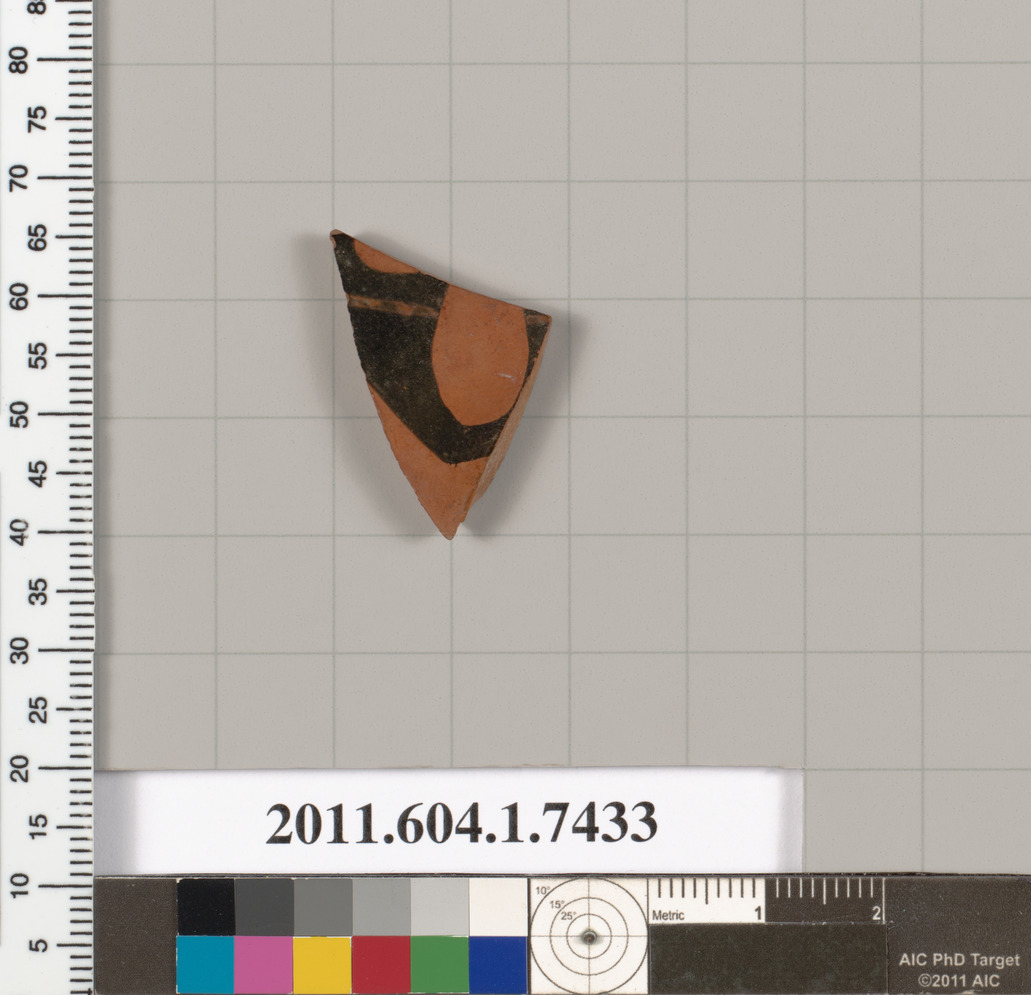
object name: kylix fragment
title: Terracotta fragment of a kylix (drinking cup)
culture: greek, attic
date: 490-470 BCE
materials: terracotta